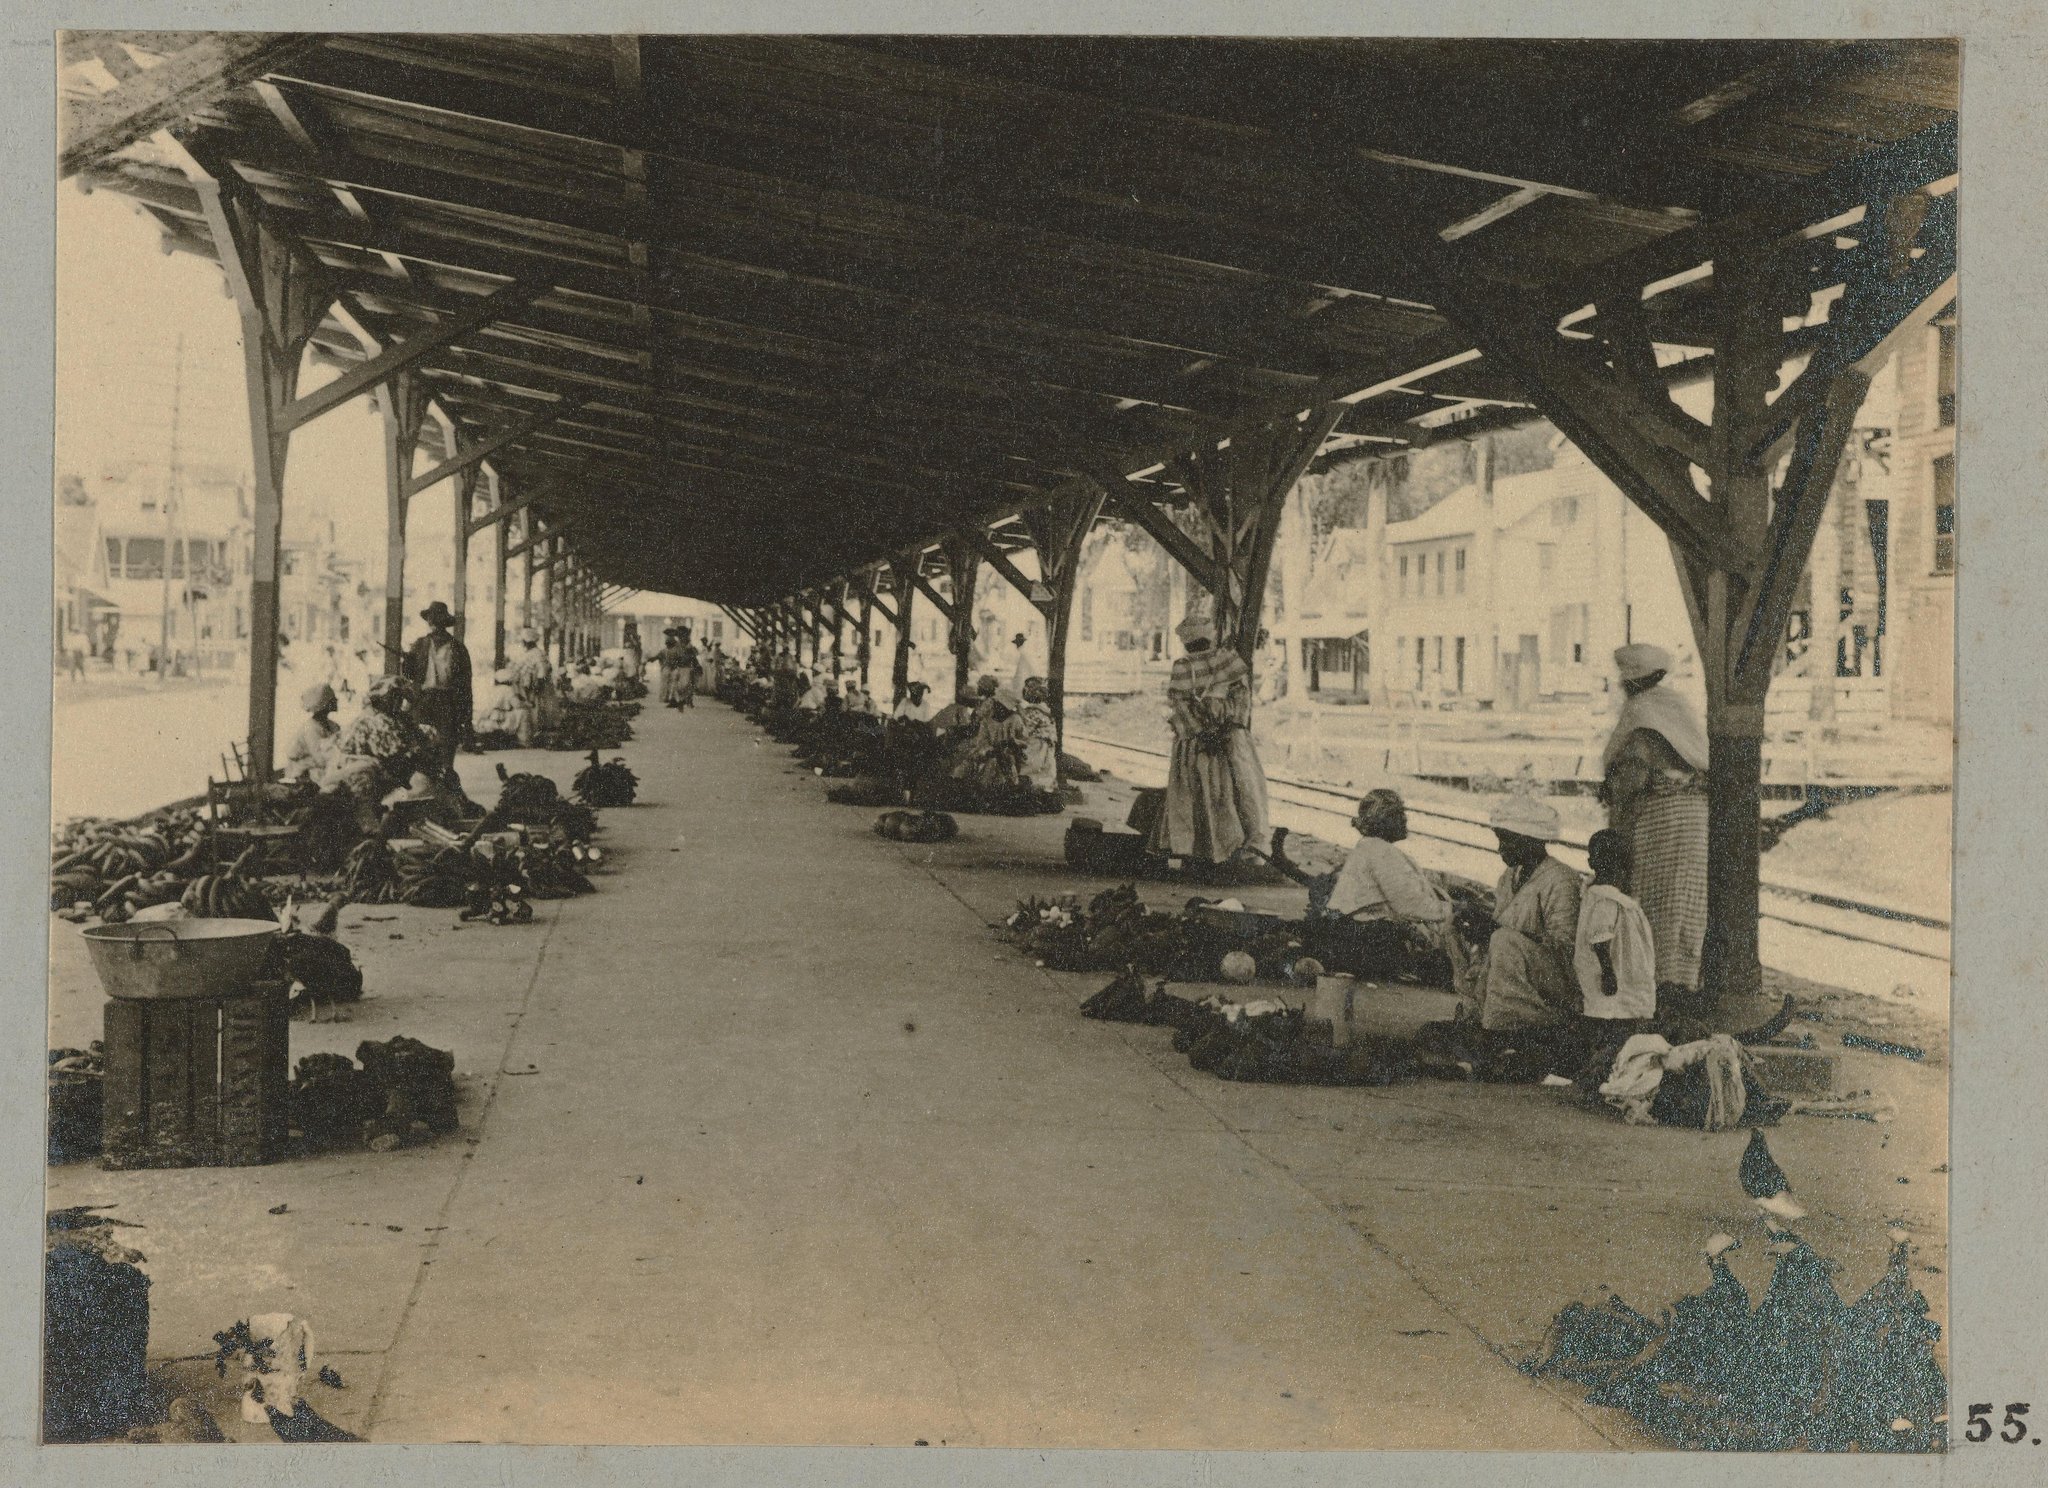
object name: photograph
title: Overdekte markt aan Heiligenweg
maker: hendrik doijer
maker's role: engineer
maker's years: 1863-1925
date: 1903-1910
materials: photographic support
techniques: gelatin silver print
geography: suriname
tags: suriname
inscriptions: inscription: ‘55. / Overdekte markt aan Heiligenweg.’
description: Gezicht in de overdekte markt aan de Heiligenweg te Paramaribo. Verkopers zitten met hun waar op de grond. Onderdeel van het fotoalbum Souvenir de Voyage (deel 2), over het leven van de familie Doijer in en rond de plantage Ma Retraite in Suriname in de jaren 1903-1910.